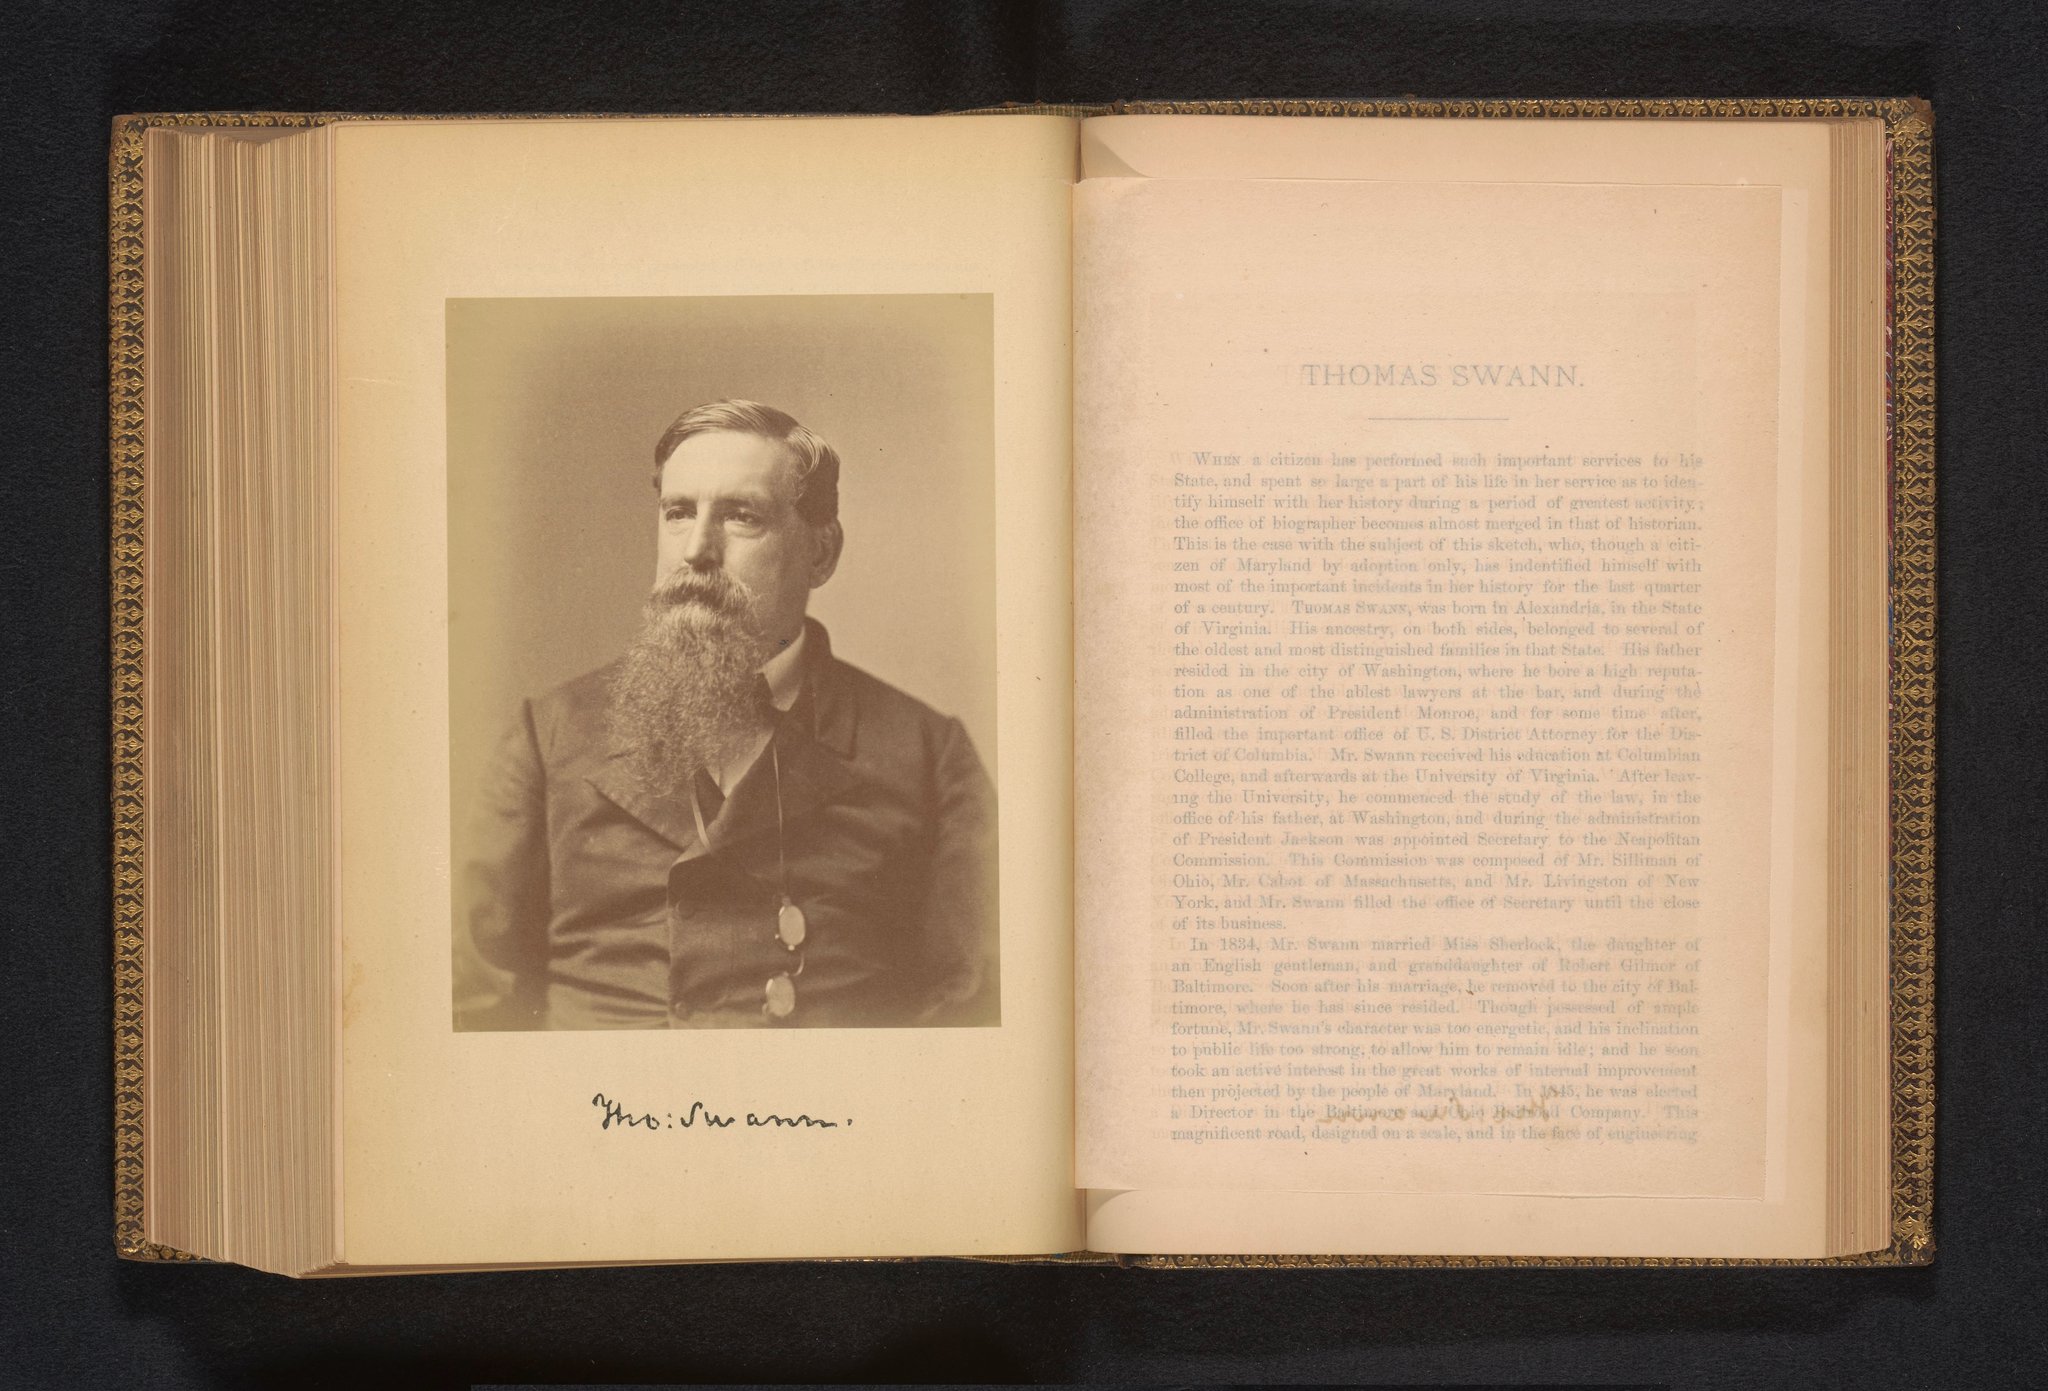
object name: page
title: Tho Swann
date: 1866-1871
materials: photographic support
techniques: albumen print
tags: politician, historical persons